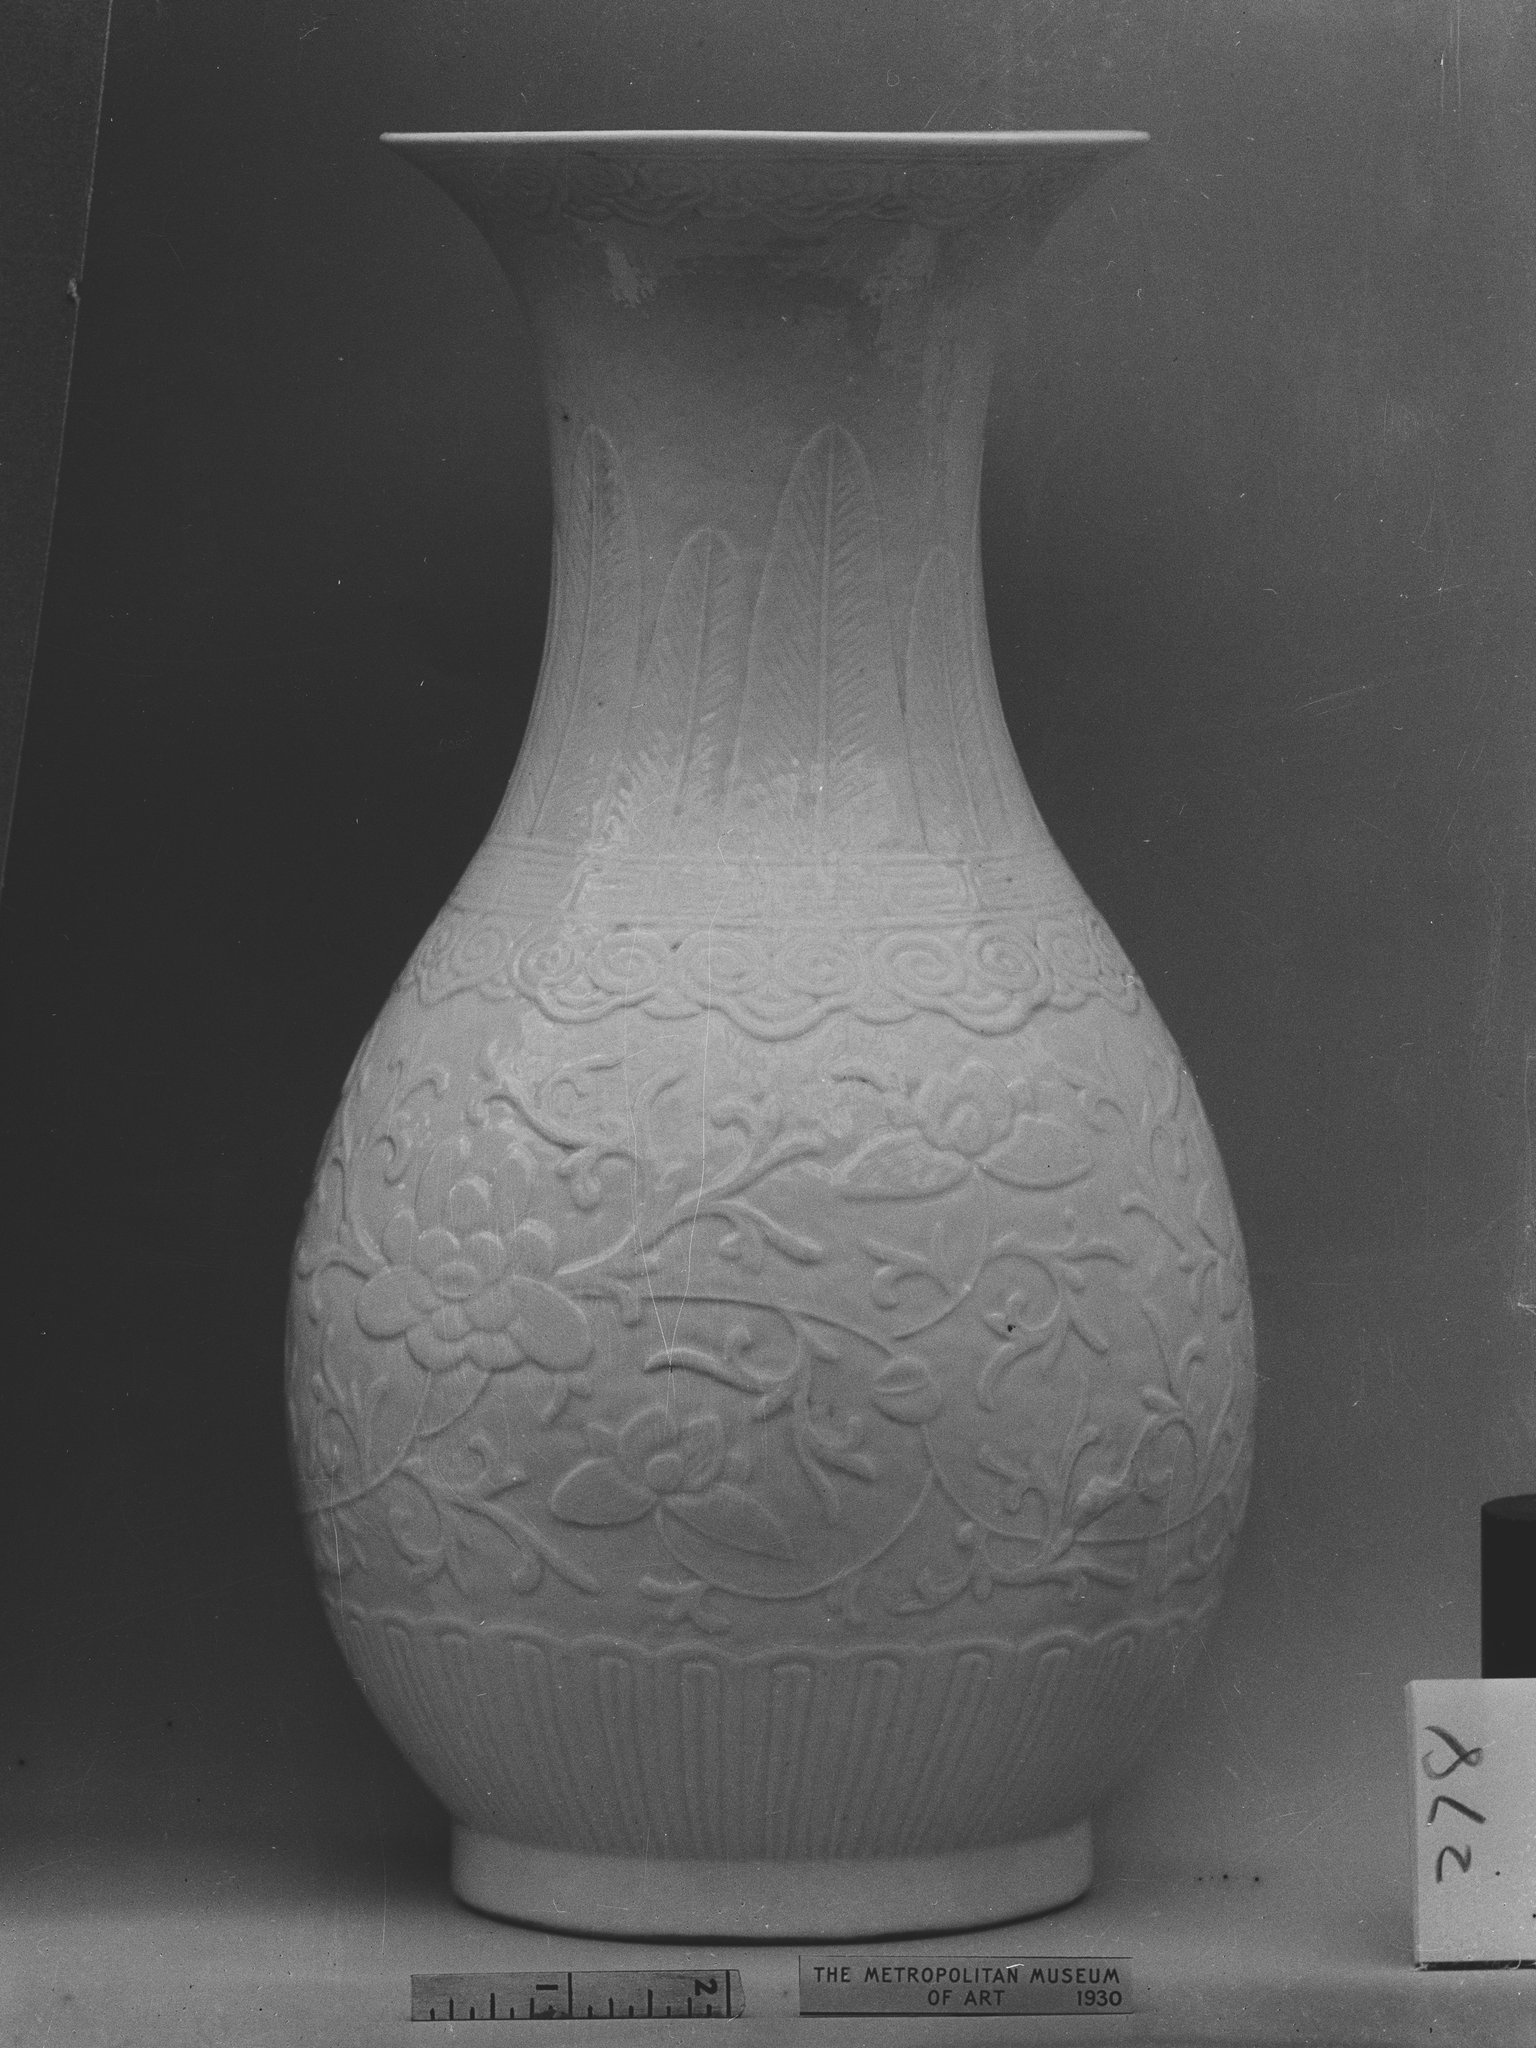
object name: vase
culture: chinese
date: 1736-1795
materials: glaze, porcelain